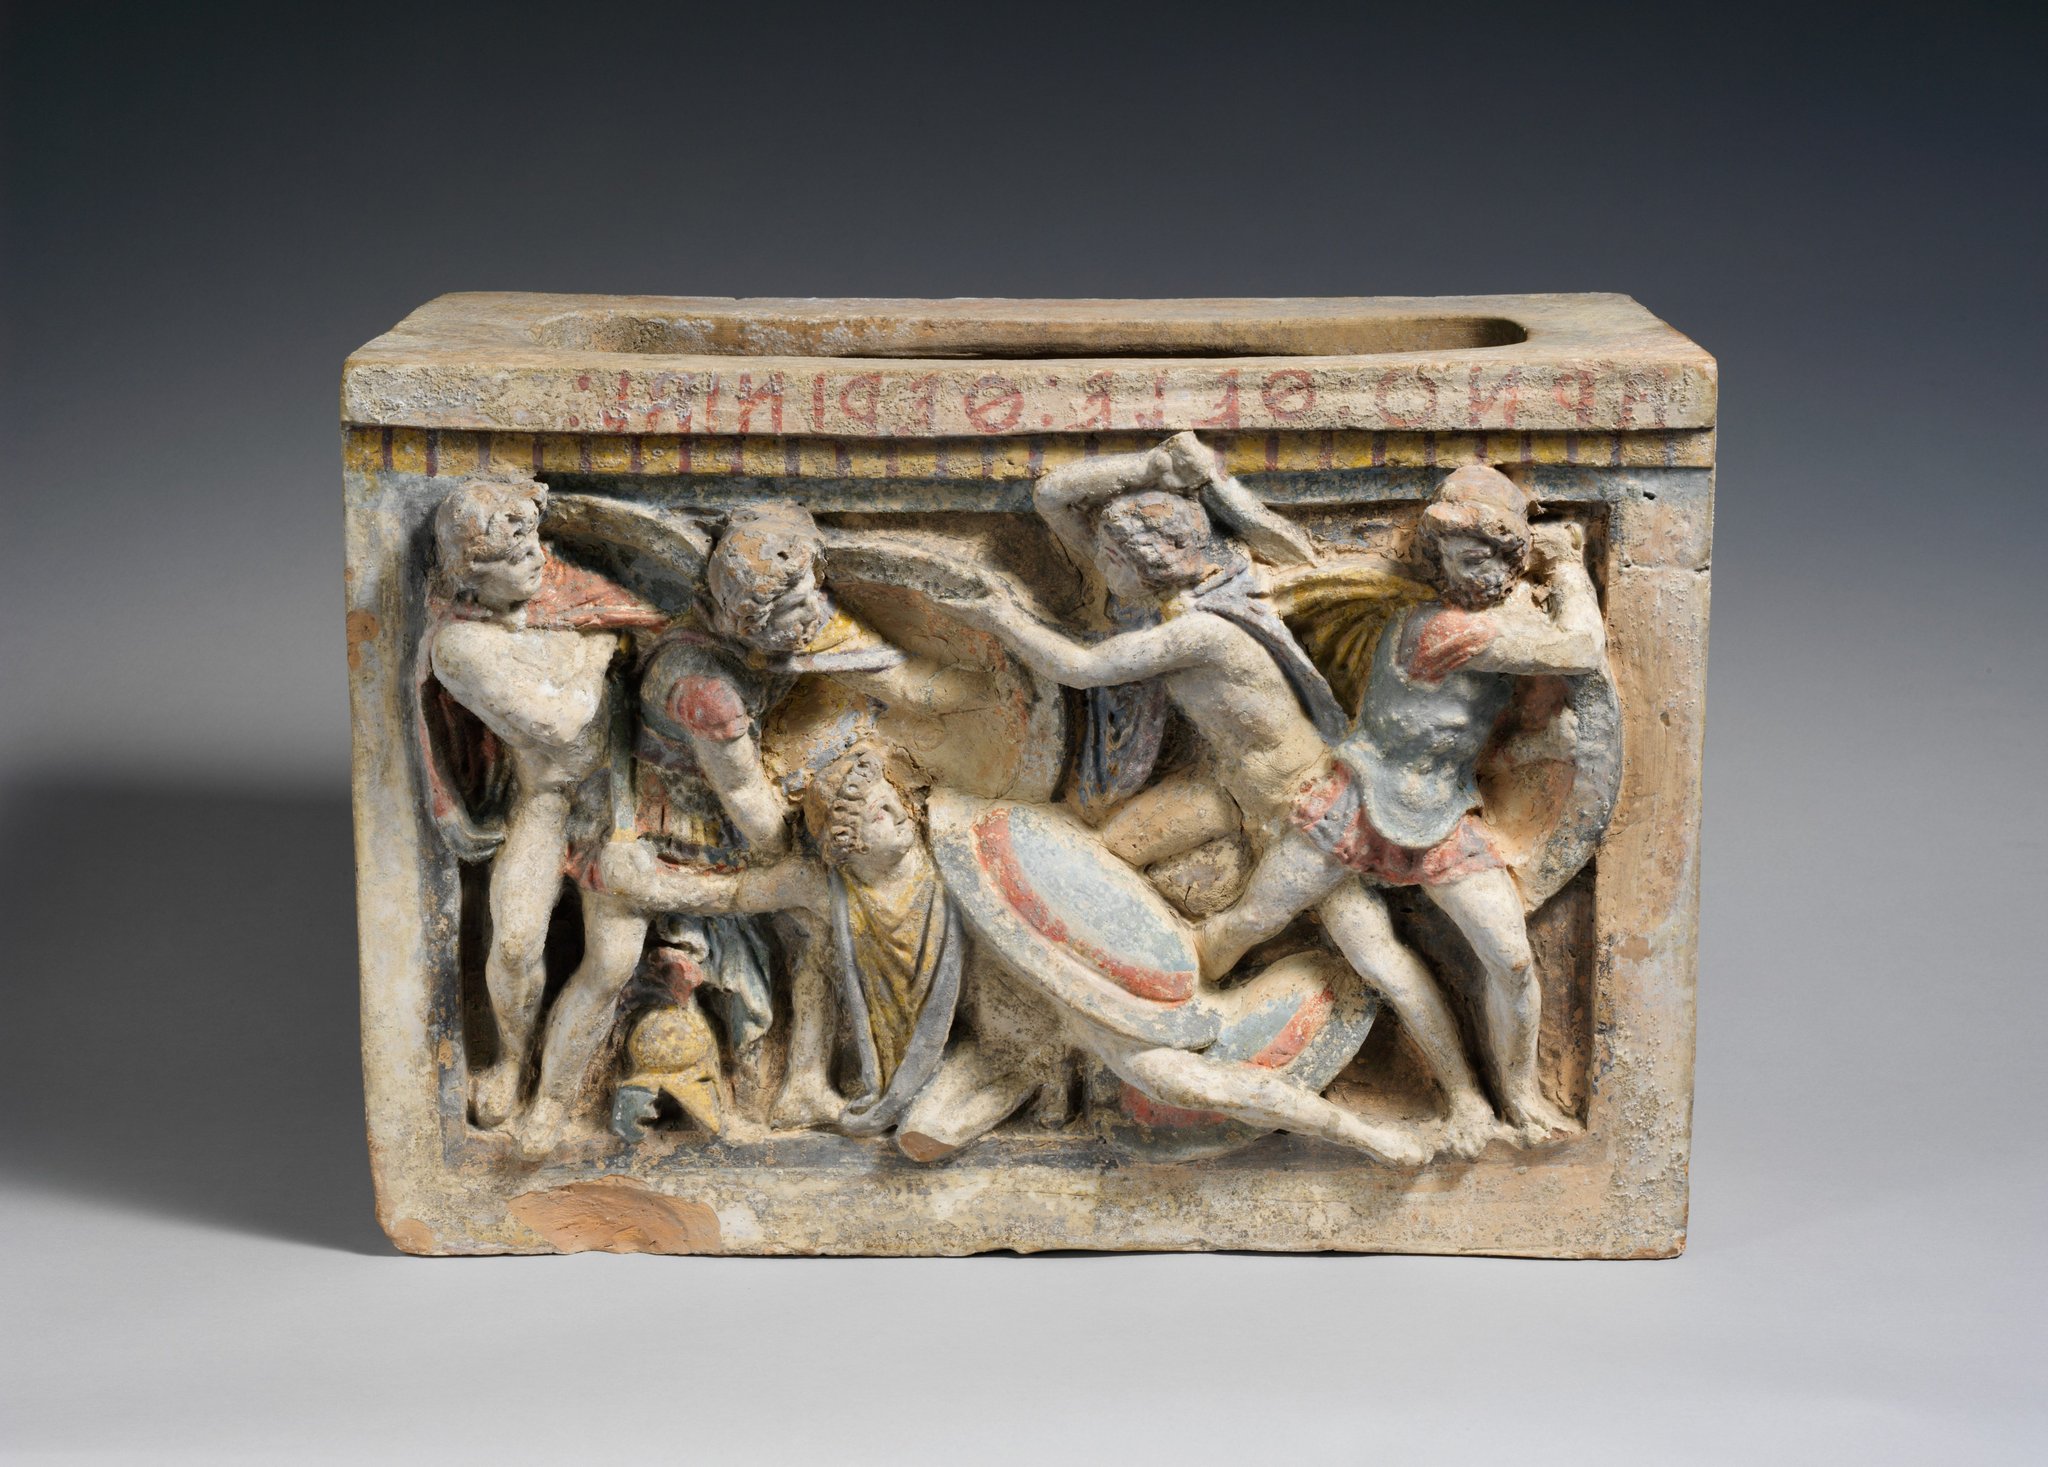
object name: cinerary urn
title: Terracotta cinerary urn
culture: etruscan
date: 300-101 BCE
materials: terracotta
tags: battles